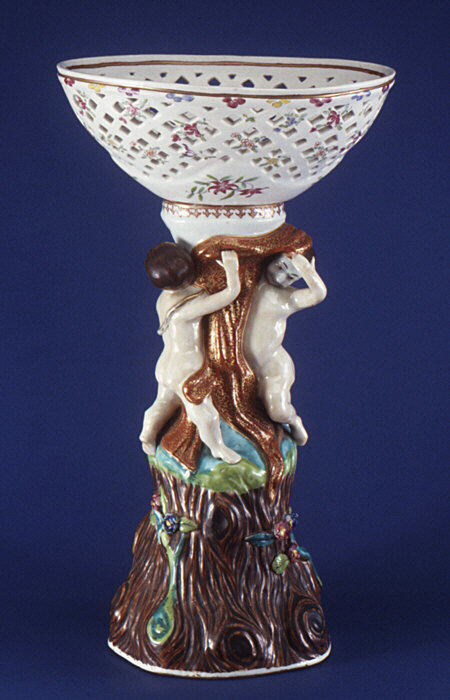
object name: fruit basket and stand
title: Fruit basket and stand (one of a pair)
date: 1790-1800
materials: hard paste porcelain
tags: putti